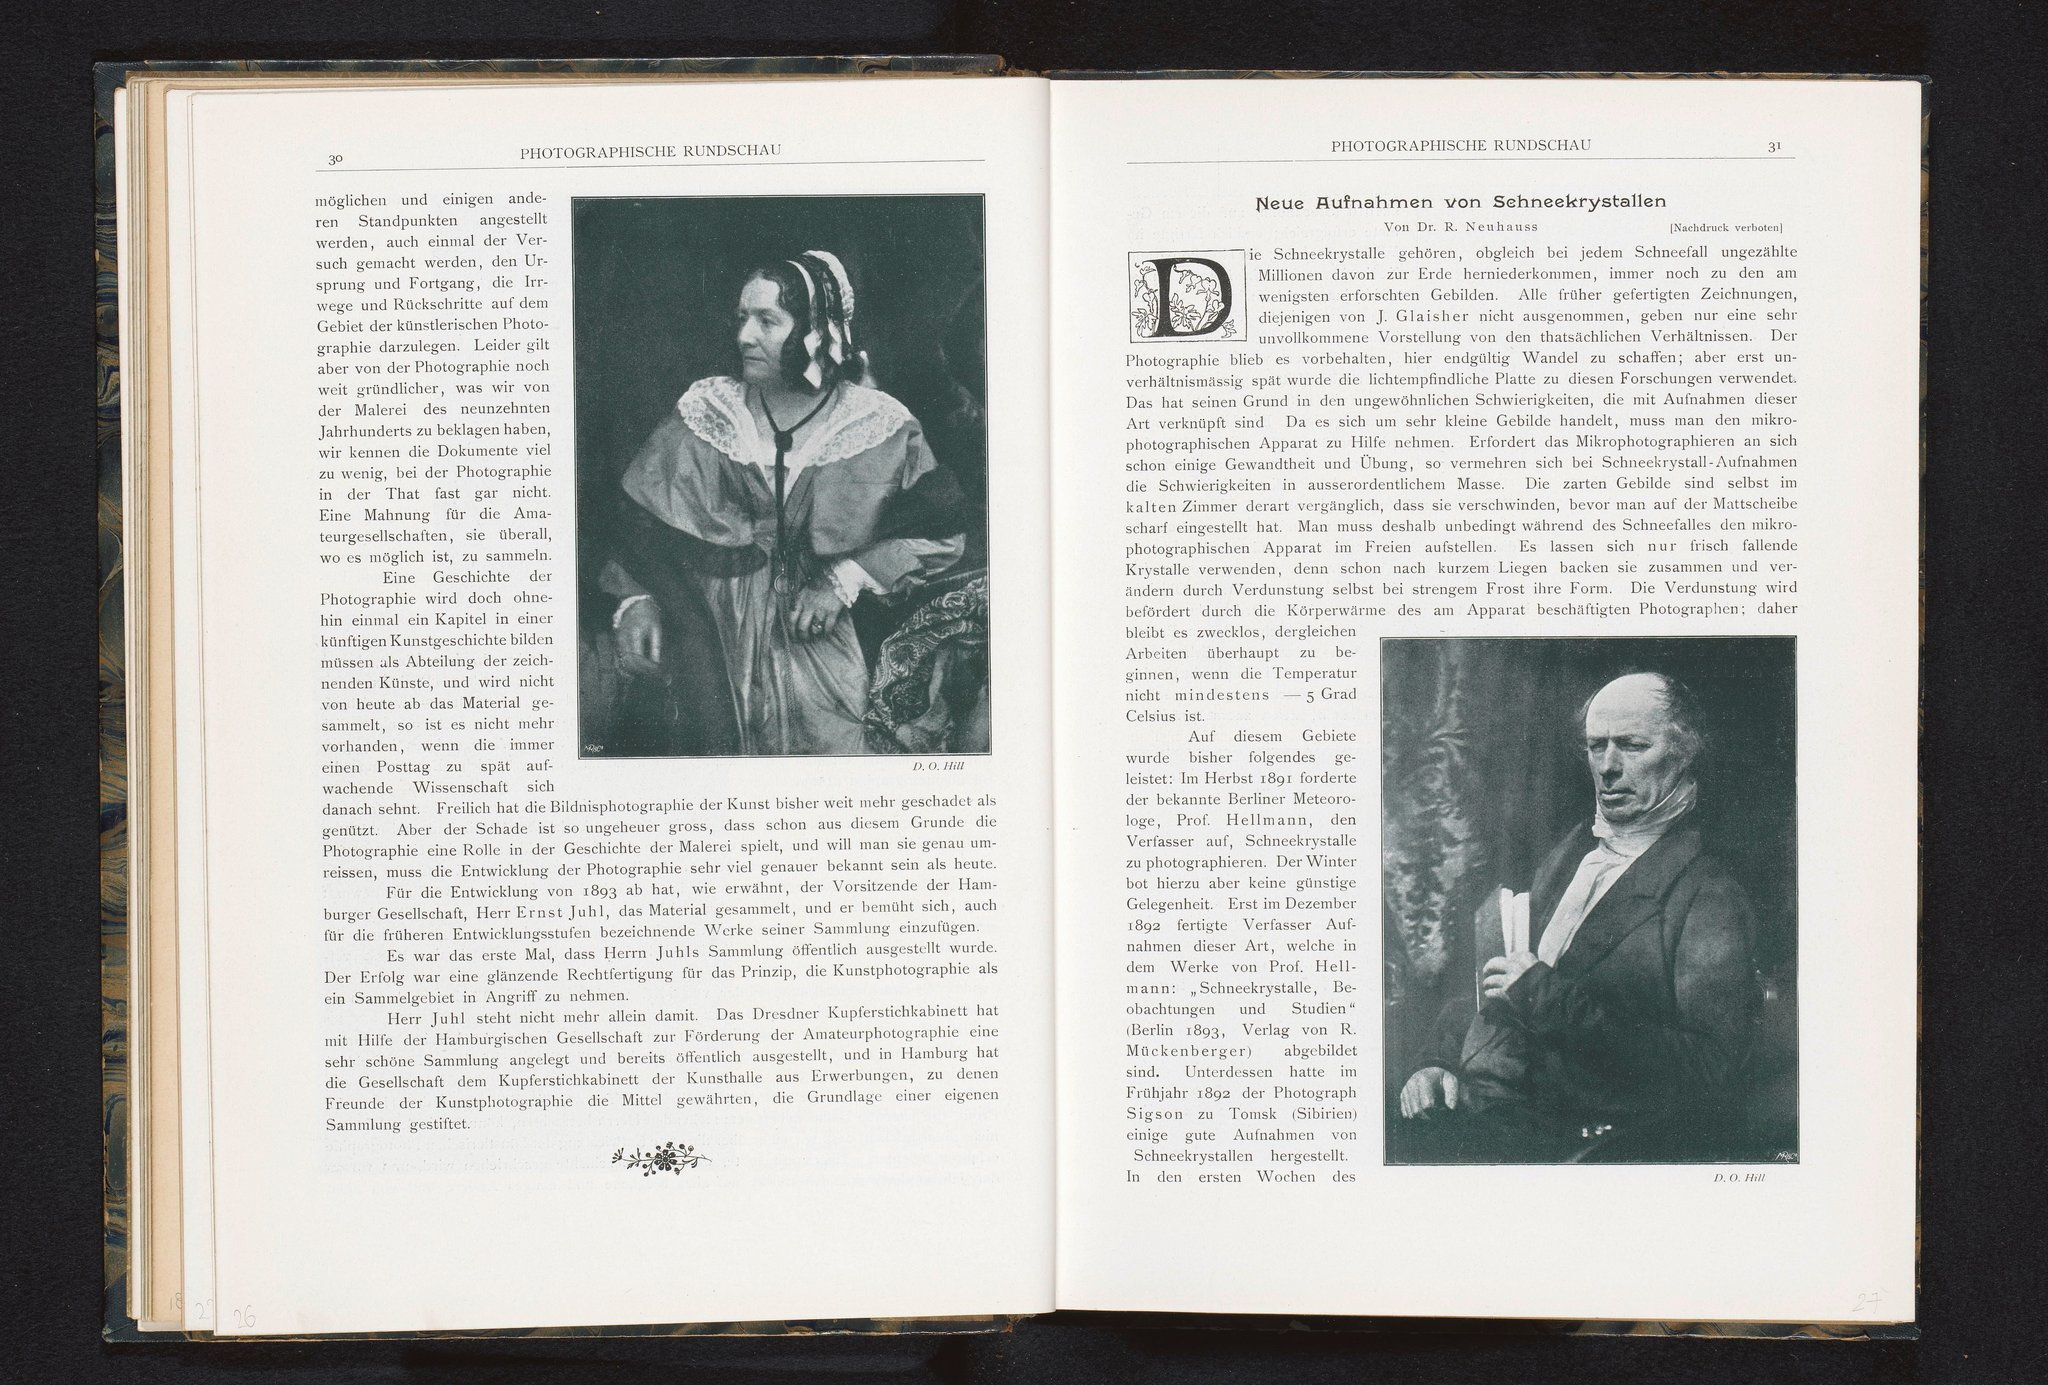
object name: page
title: Portret van een onbekende vrouw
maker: david octavius hill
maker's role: fotograaf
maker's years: 1802-1870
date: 1895-1900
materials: paper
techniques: autotype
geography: berlin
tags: adult woman, historical persons